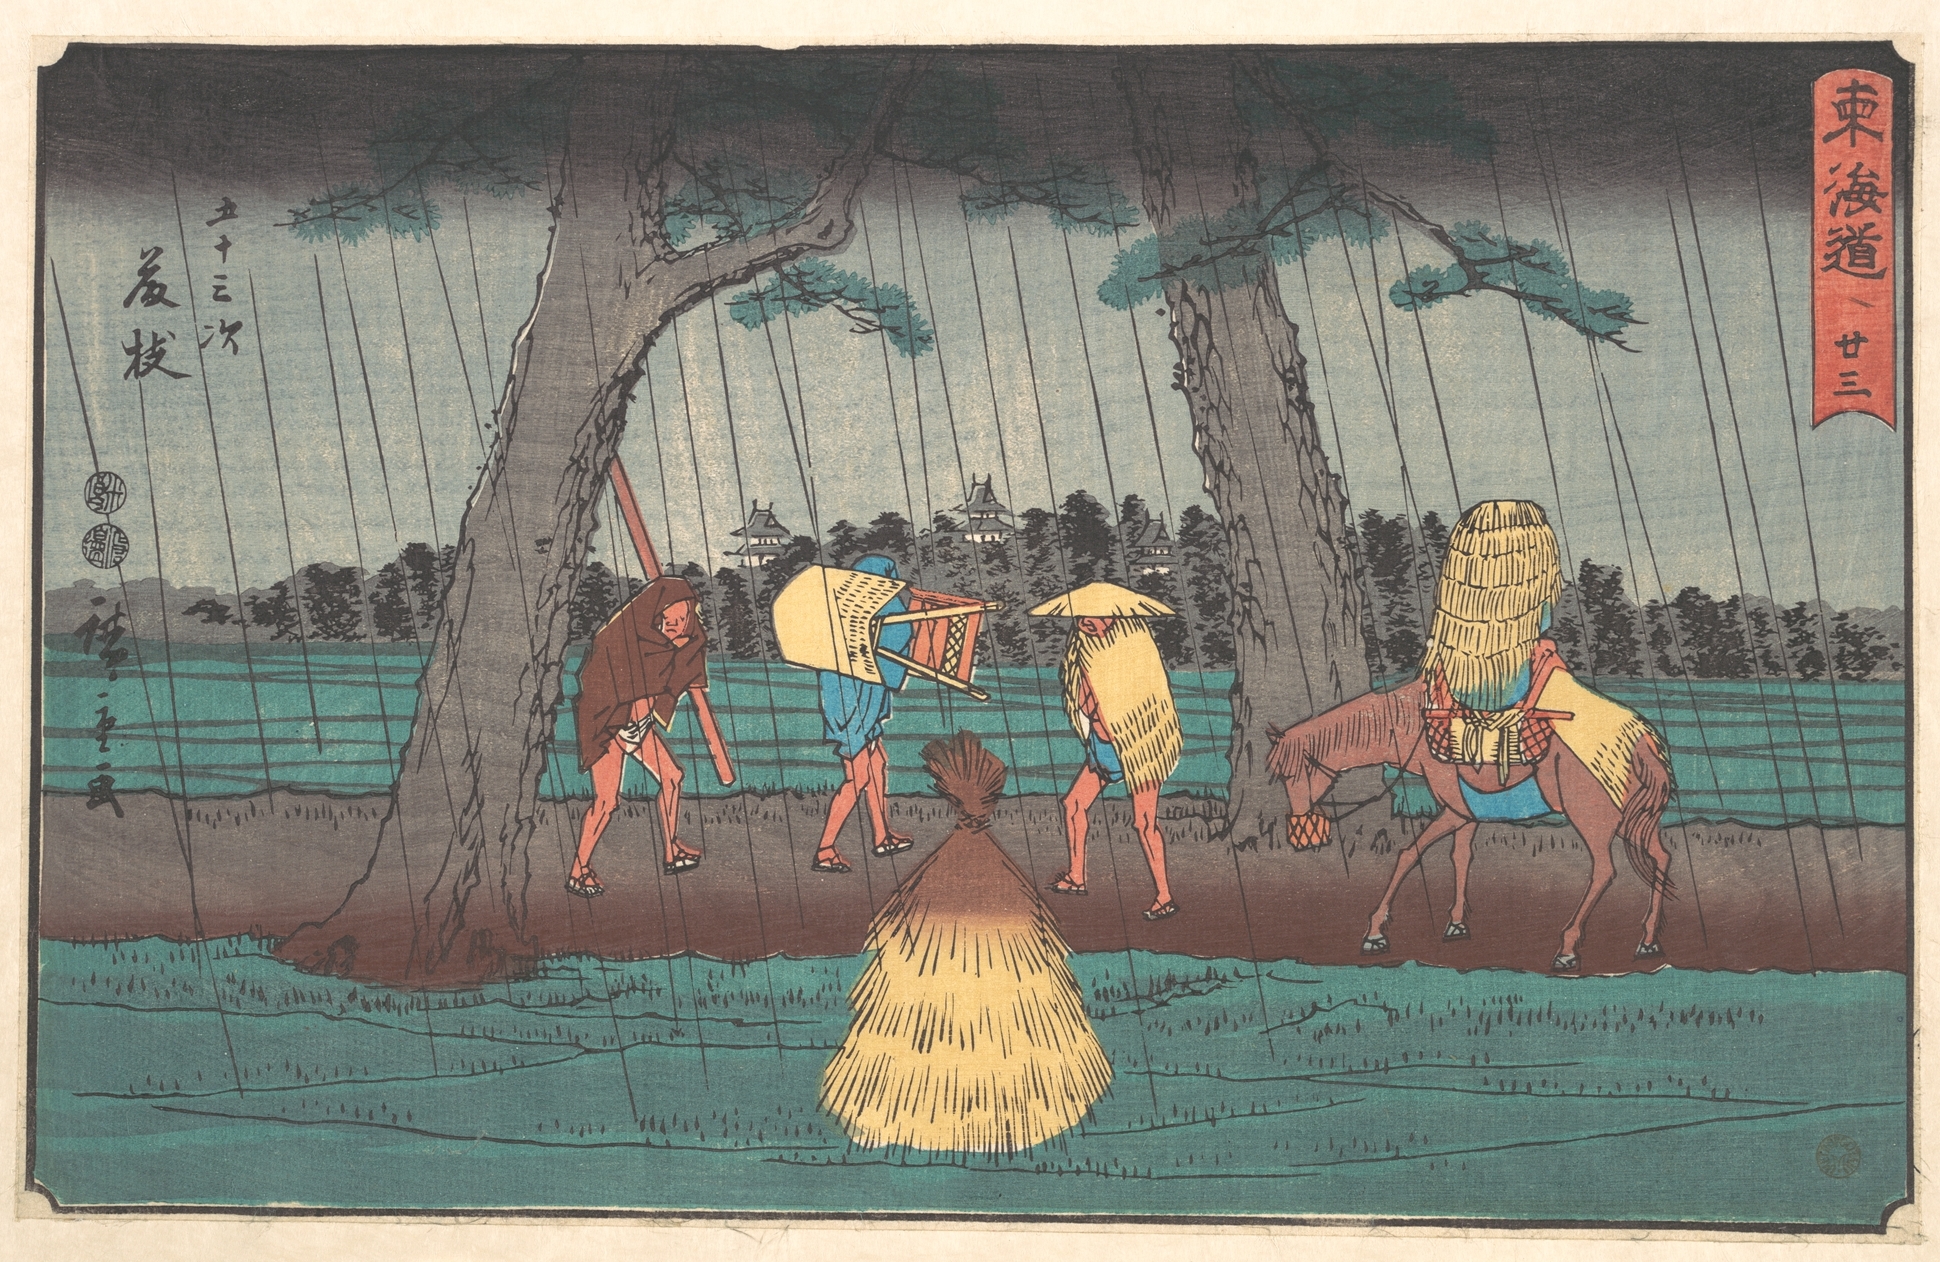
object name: print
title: Fujieda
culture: japanese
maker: utagawa hiroshige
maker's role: artist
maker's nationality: japanese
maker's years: 1797-1858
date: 1840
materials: ink, paper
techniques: woodblock print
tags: men,horses,trees,working